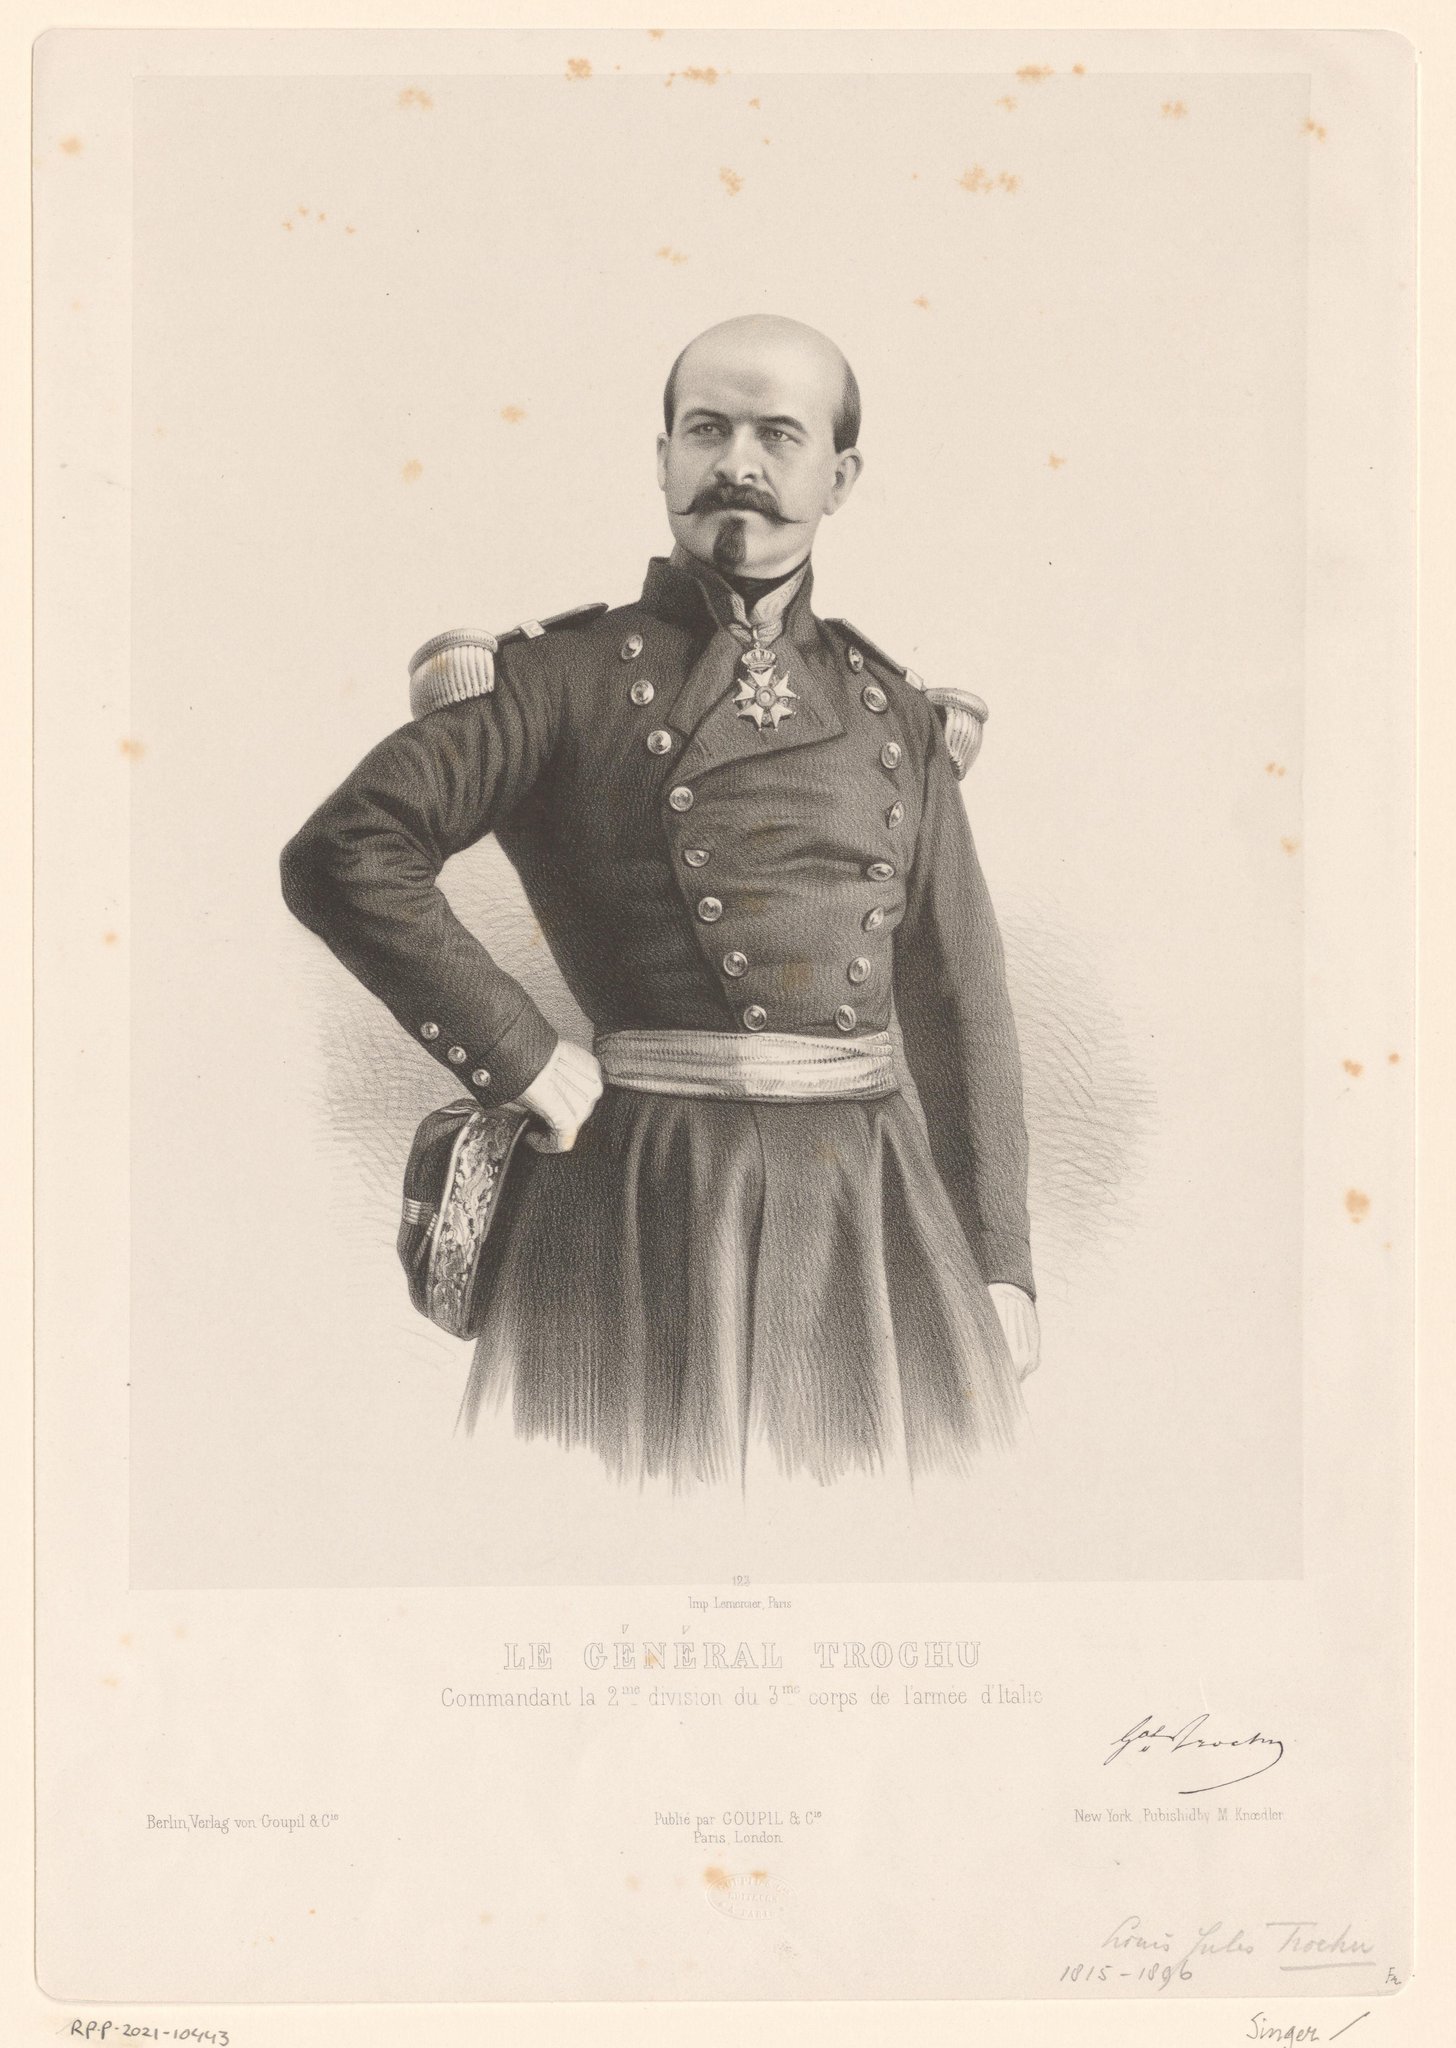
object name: print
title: Portret van Louis Jules Trochu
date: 1857-1878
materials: paper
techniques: lithograph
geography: paris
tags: adult man, historical persons, (military) uniforms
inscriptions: check stamp: Lugt 1090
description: Midden onder genummerd: 123. Signatuur in facsimile.